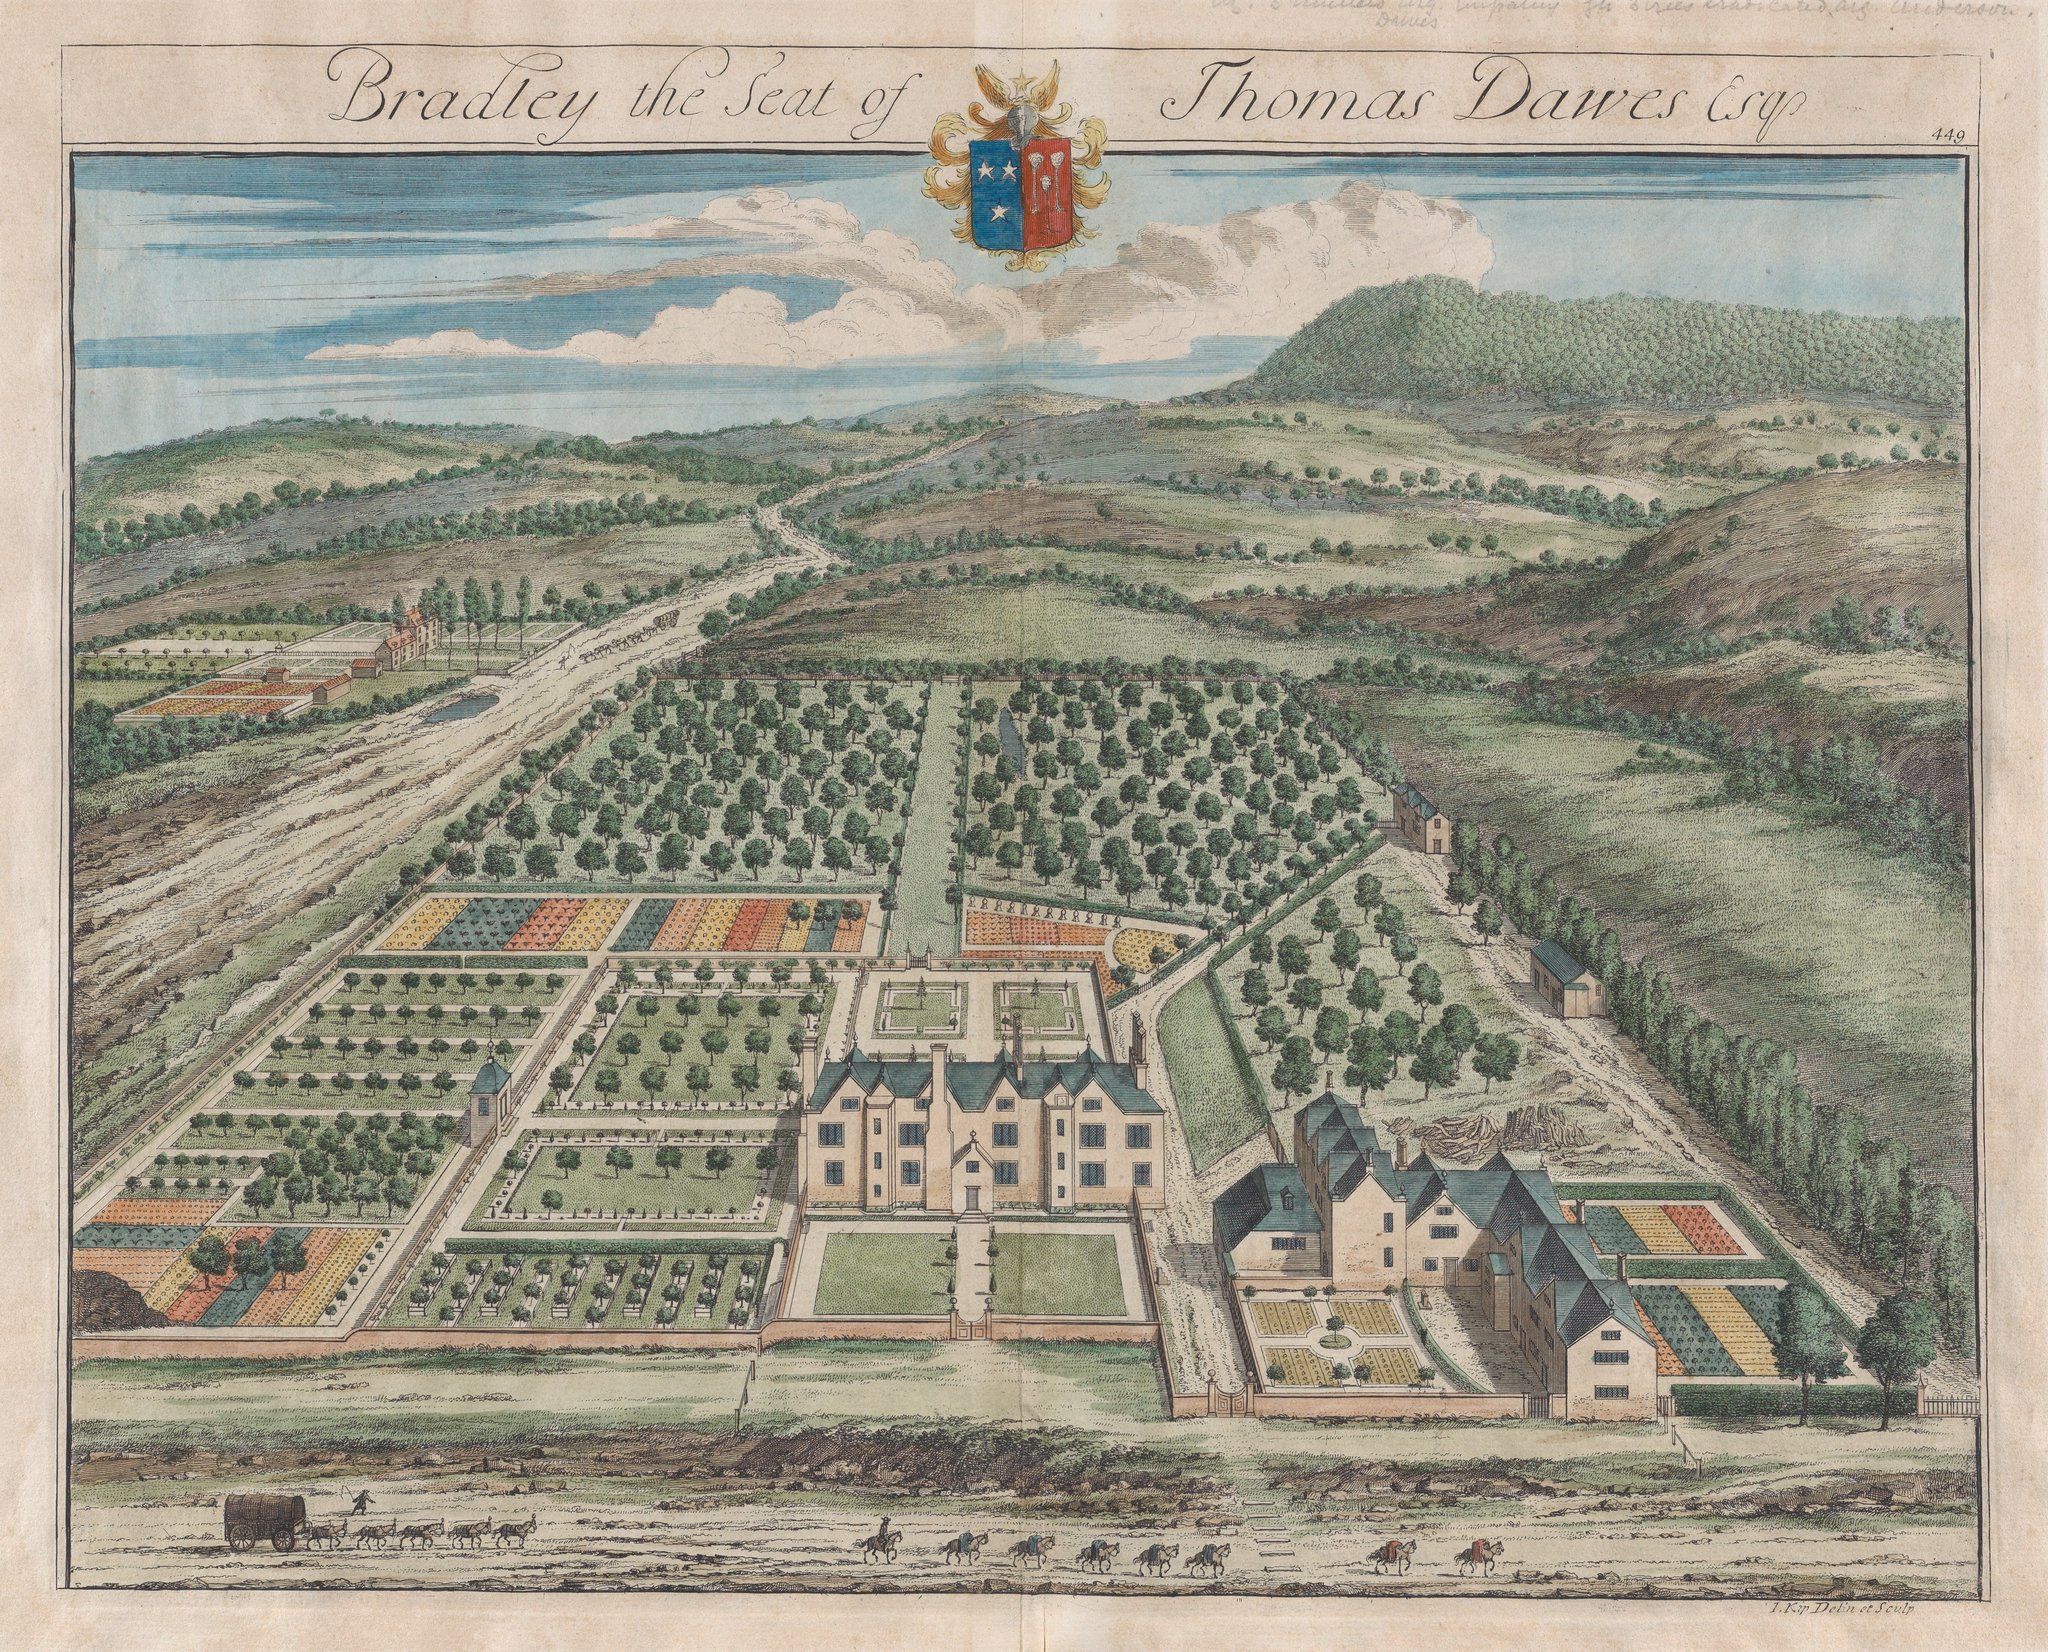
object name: print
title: Bradley, The Seat of Thomas Dawes, plate 449 from "The Ancient and Present State of Gloucestershire"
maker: johannes kip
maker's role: artist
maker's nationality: dutch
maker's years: 1653-1722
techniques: engraving, etching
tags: houses,gardens,landscapes,coat of arms